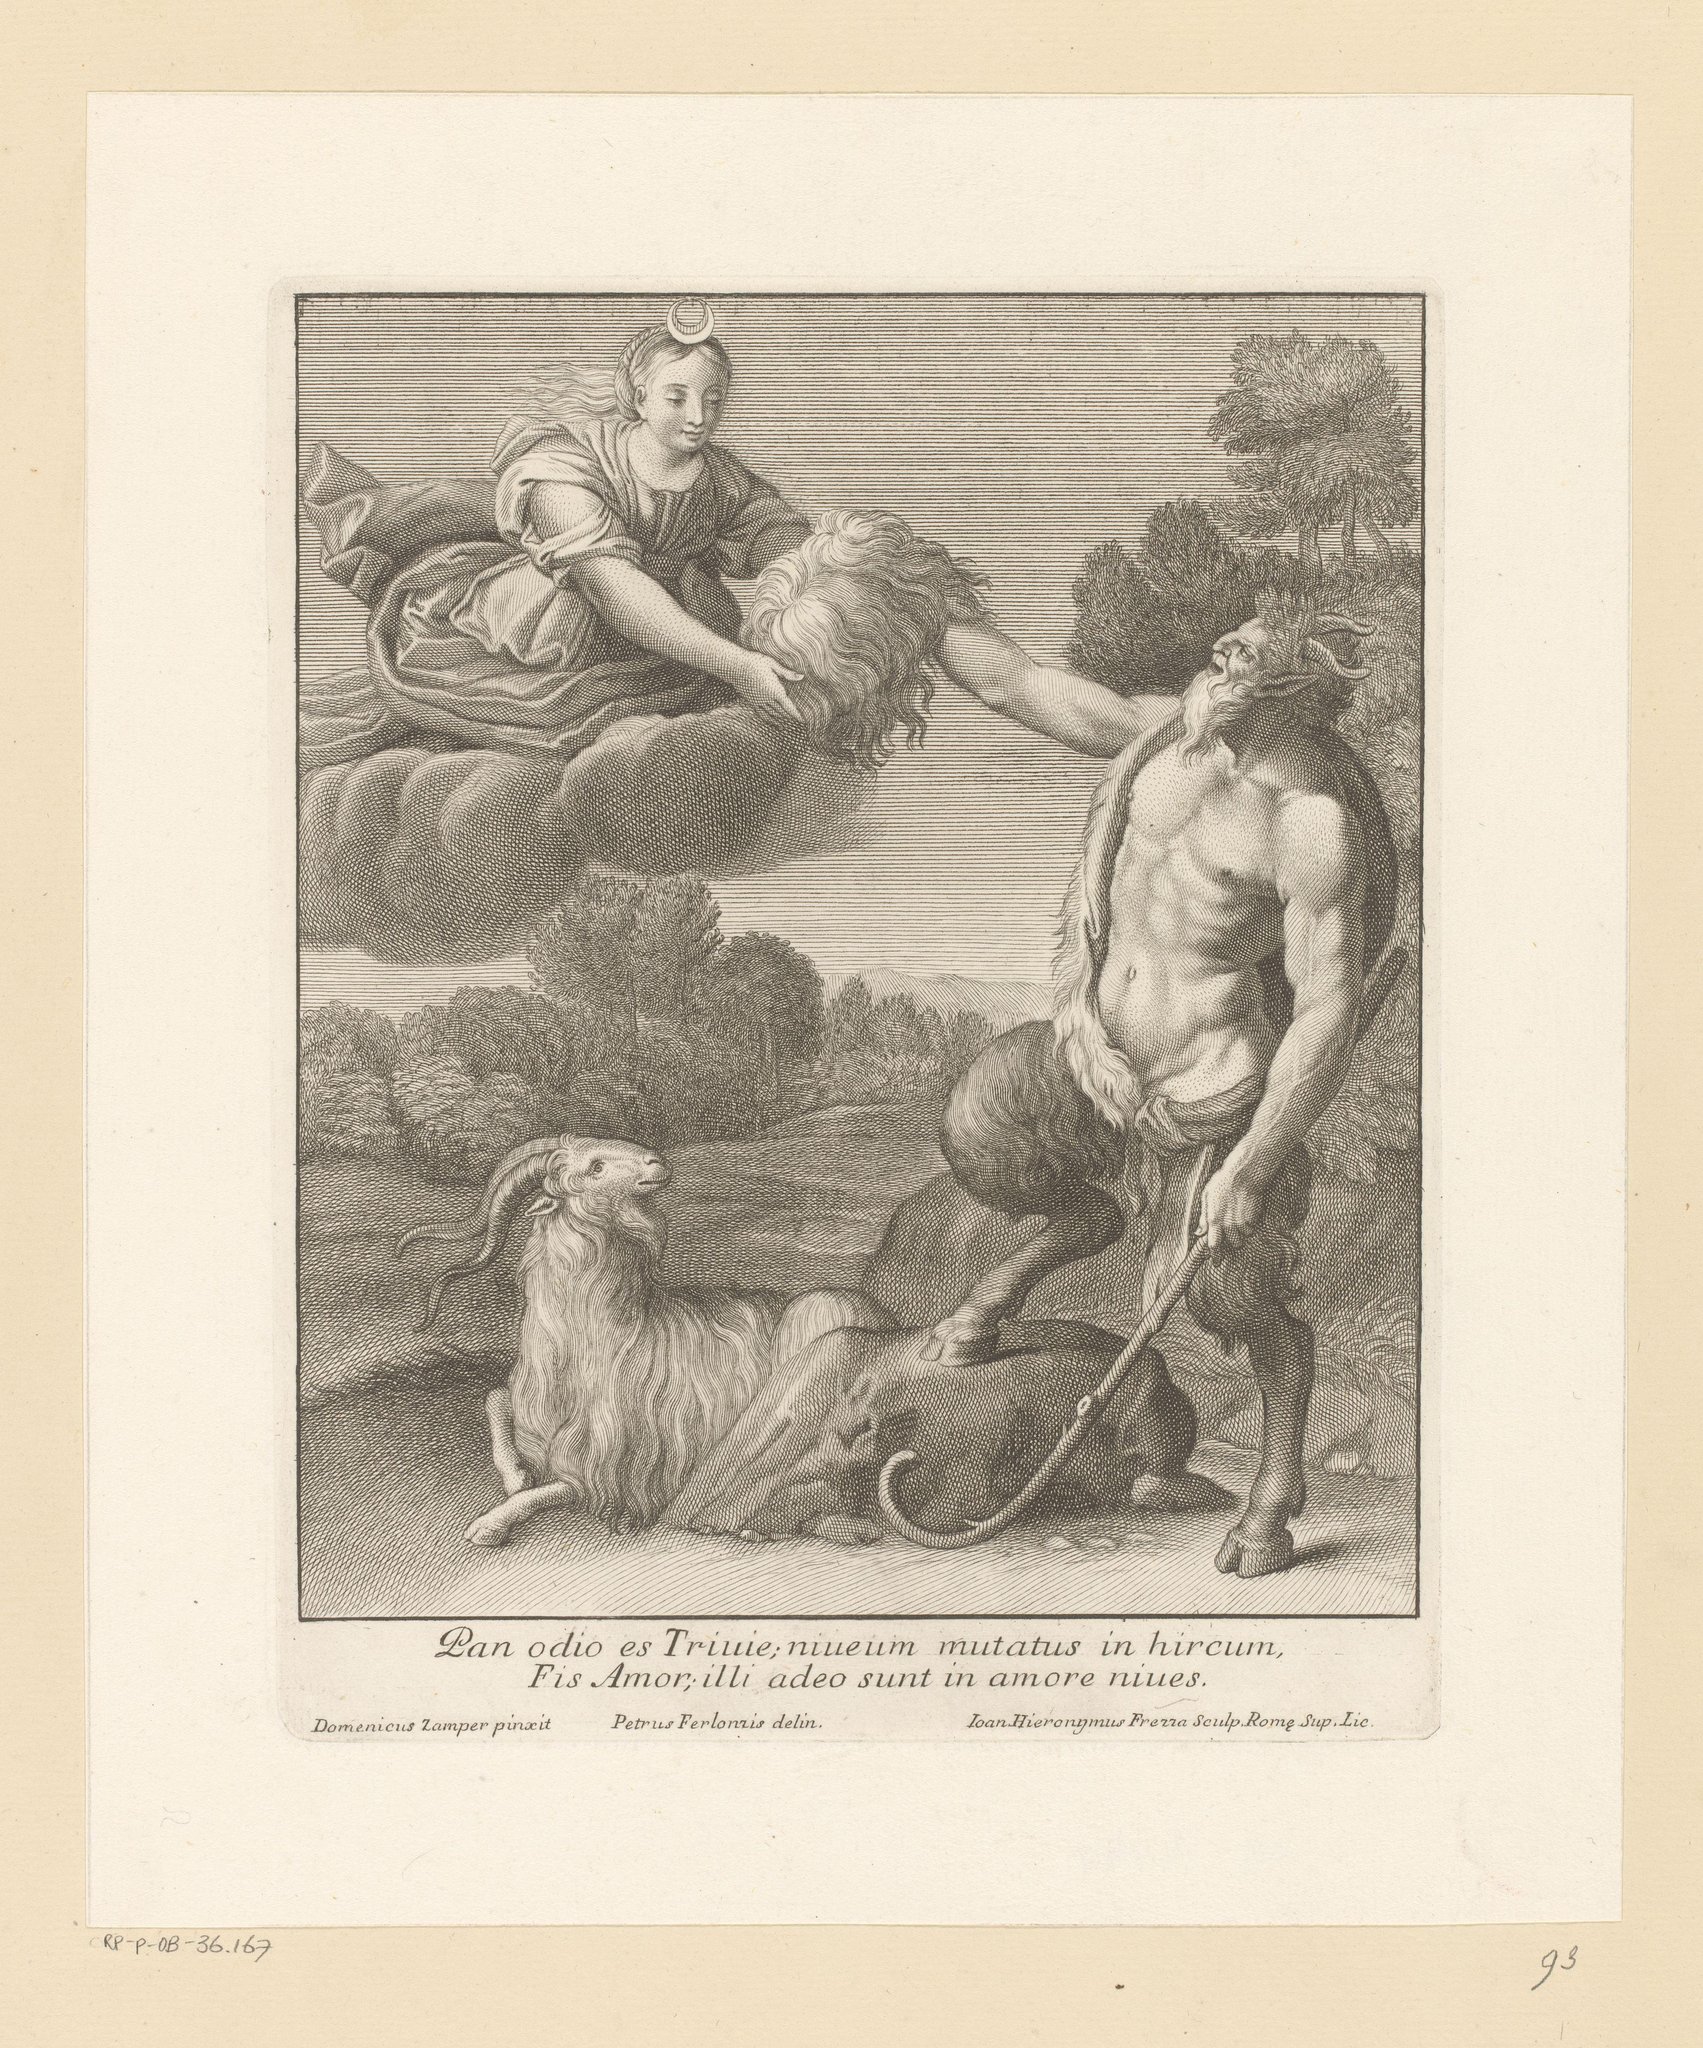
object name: print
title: Het leven van Diana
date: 1686-1748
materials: paper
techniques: engraving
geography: italy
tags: diana (luna) allured by pan with a fleece or a bundle of wool (virgil, 'georg.' iii 391-393)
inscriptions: collector's mark: Lugt 240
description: Naar een fresco door Domenichino in het Palazzo Giustiniani-Odescalchi in Bassano di Sutri. Prent uit een reeks prenten met als onderwerp het leven van Diana.